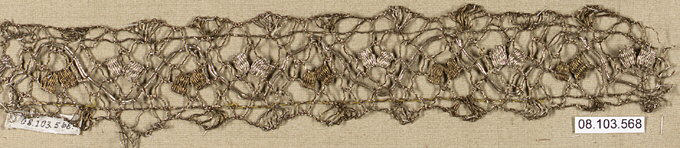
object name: piece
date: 1701-1800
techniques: lace